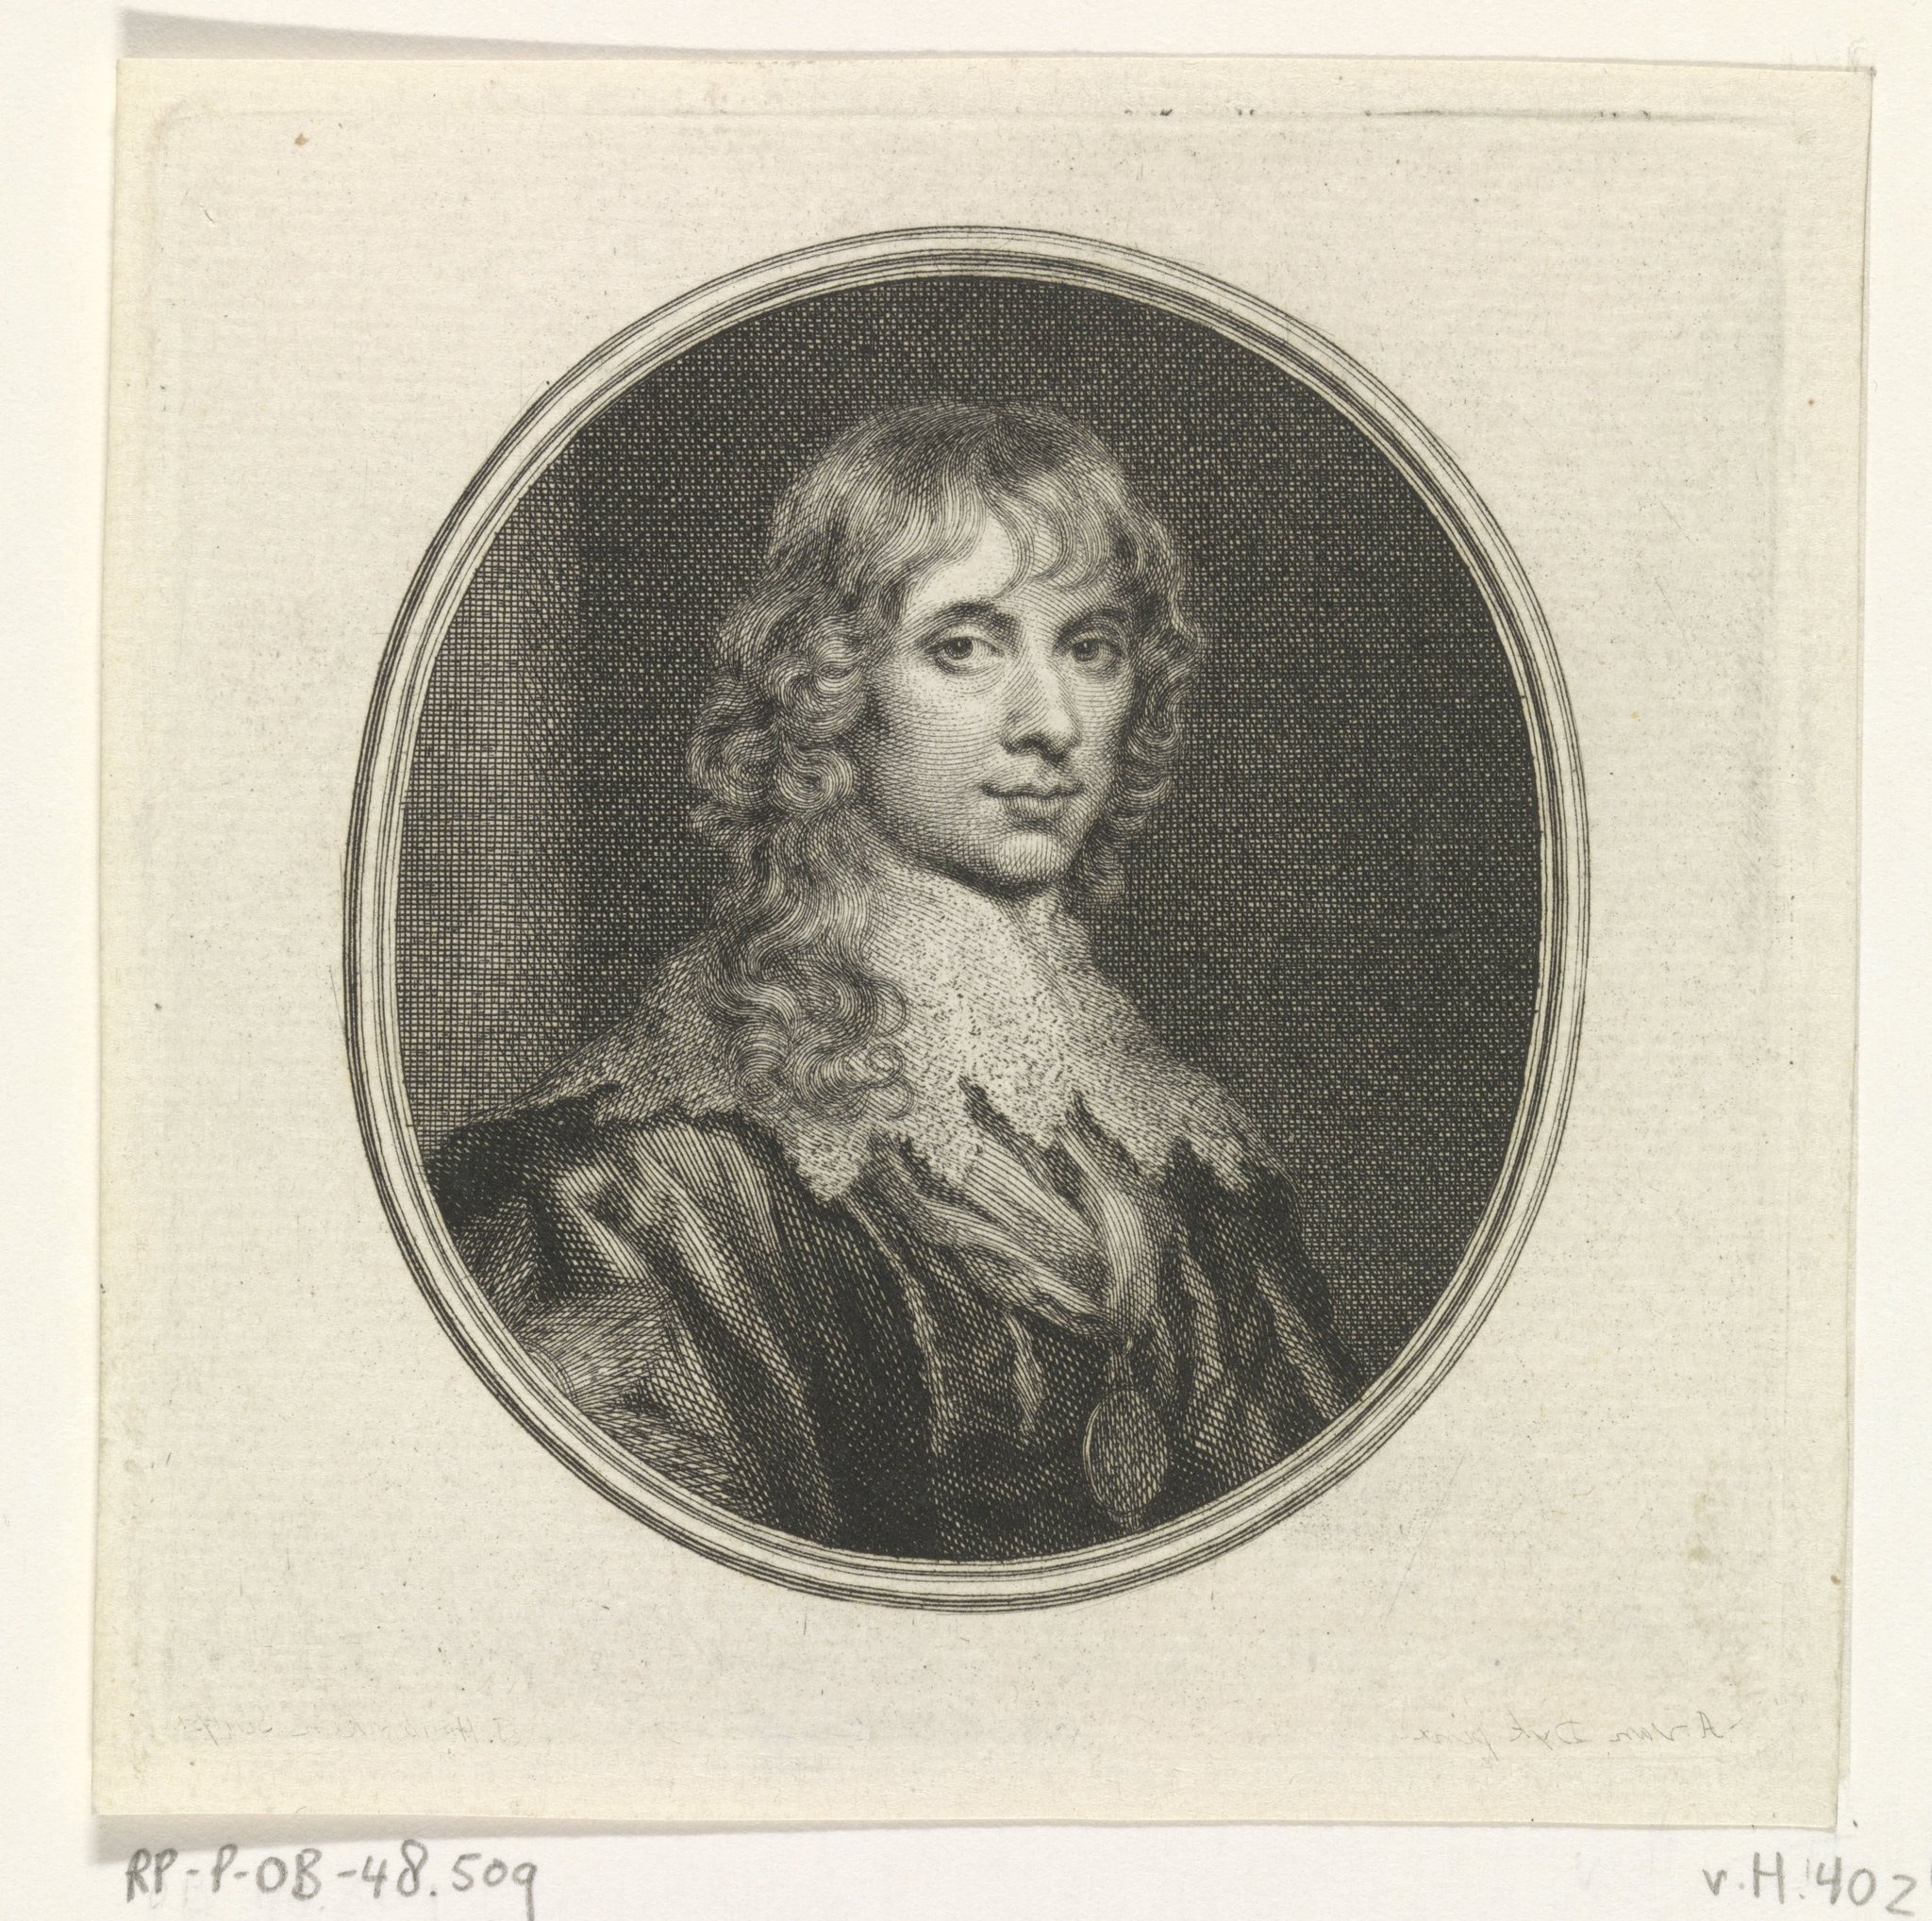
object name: print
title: Portret van James Stuart, hertog van Richmond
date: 1708-1780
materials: paper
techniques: engraving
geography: amsterdam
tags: prins, james stuart (1e hertog van richmond en 4e hertog van lennox)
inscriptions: collector's mark: Lugt 2228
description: Buste naar rechts van James Stuart, hertog van Richmond, in een ovaal medaillon.